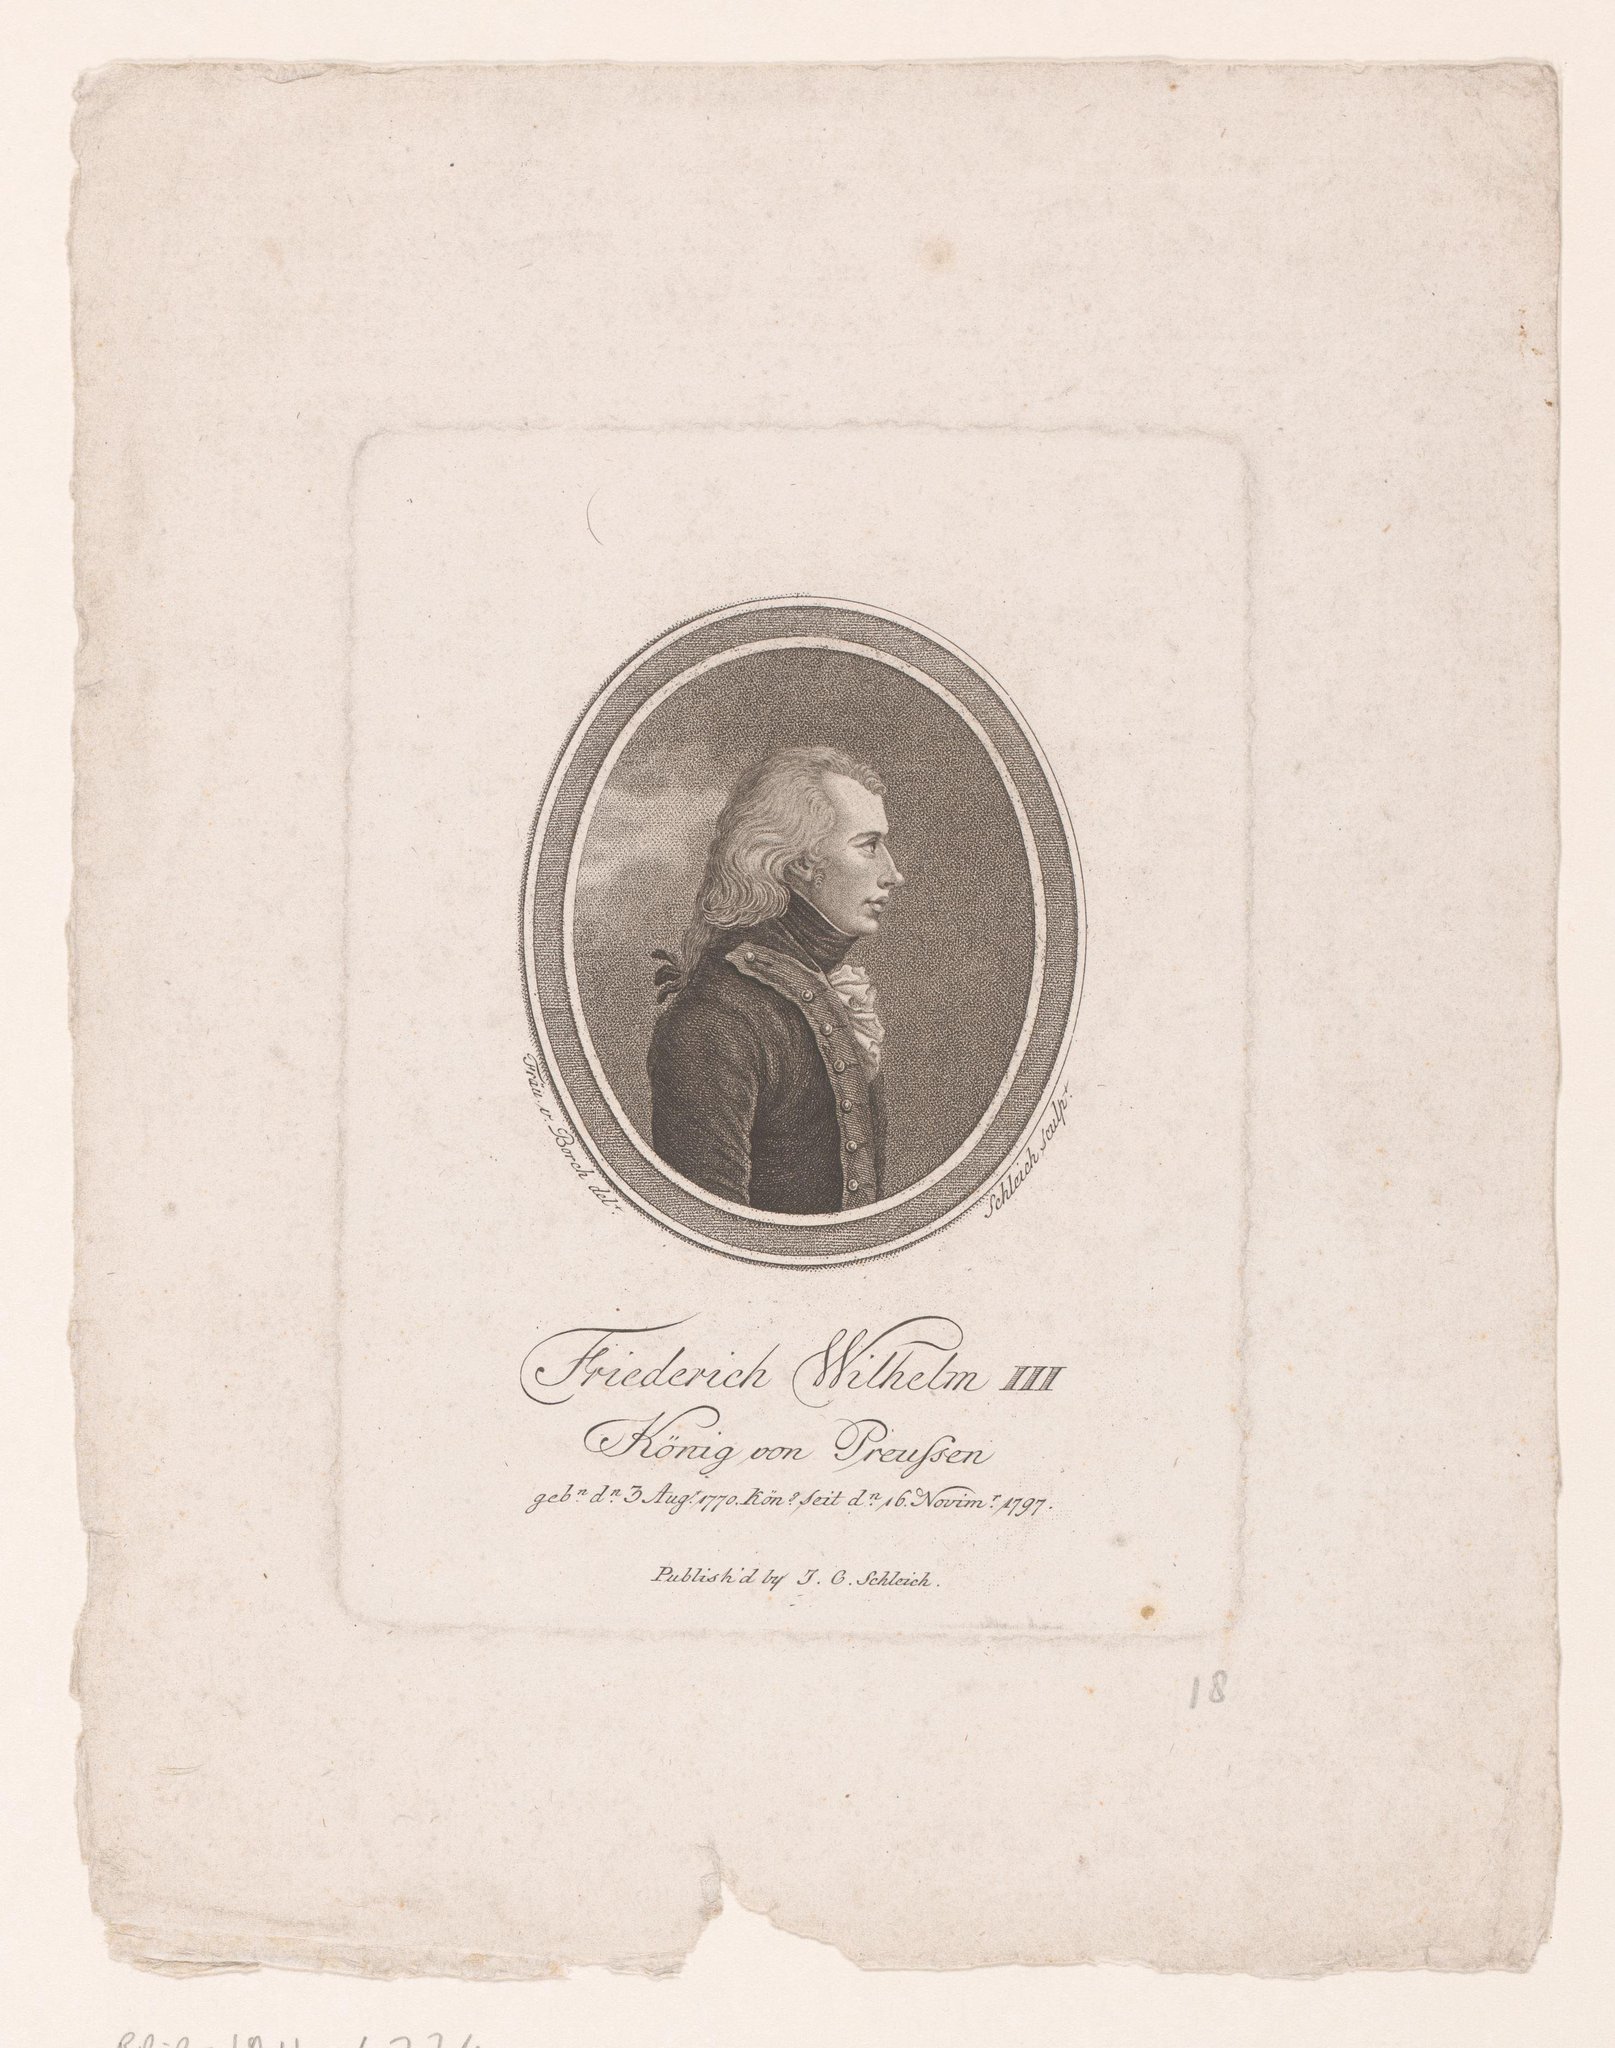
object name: print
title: Portret van Friedrich Wilhelm III van Pruisen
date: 1797-1842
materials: paper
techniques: engraving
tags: berlin, frederik willem iii koning van pruisen, historical persons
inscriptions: collector's mark: Lugt 2228